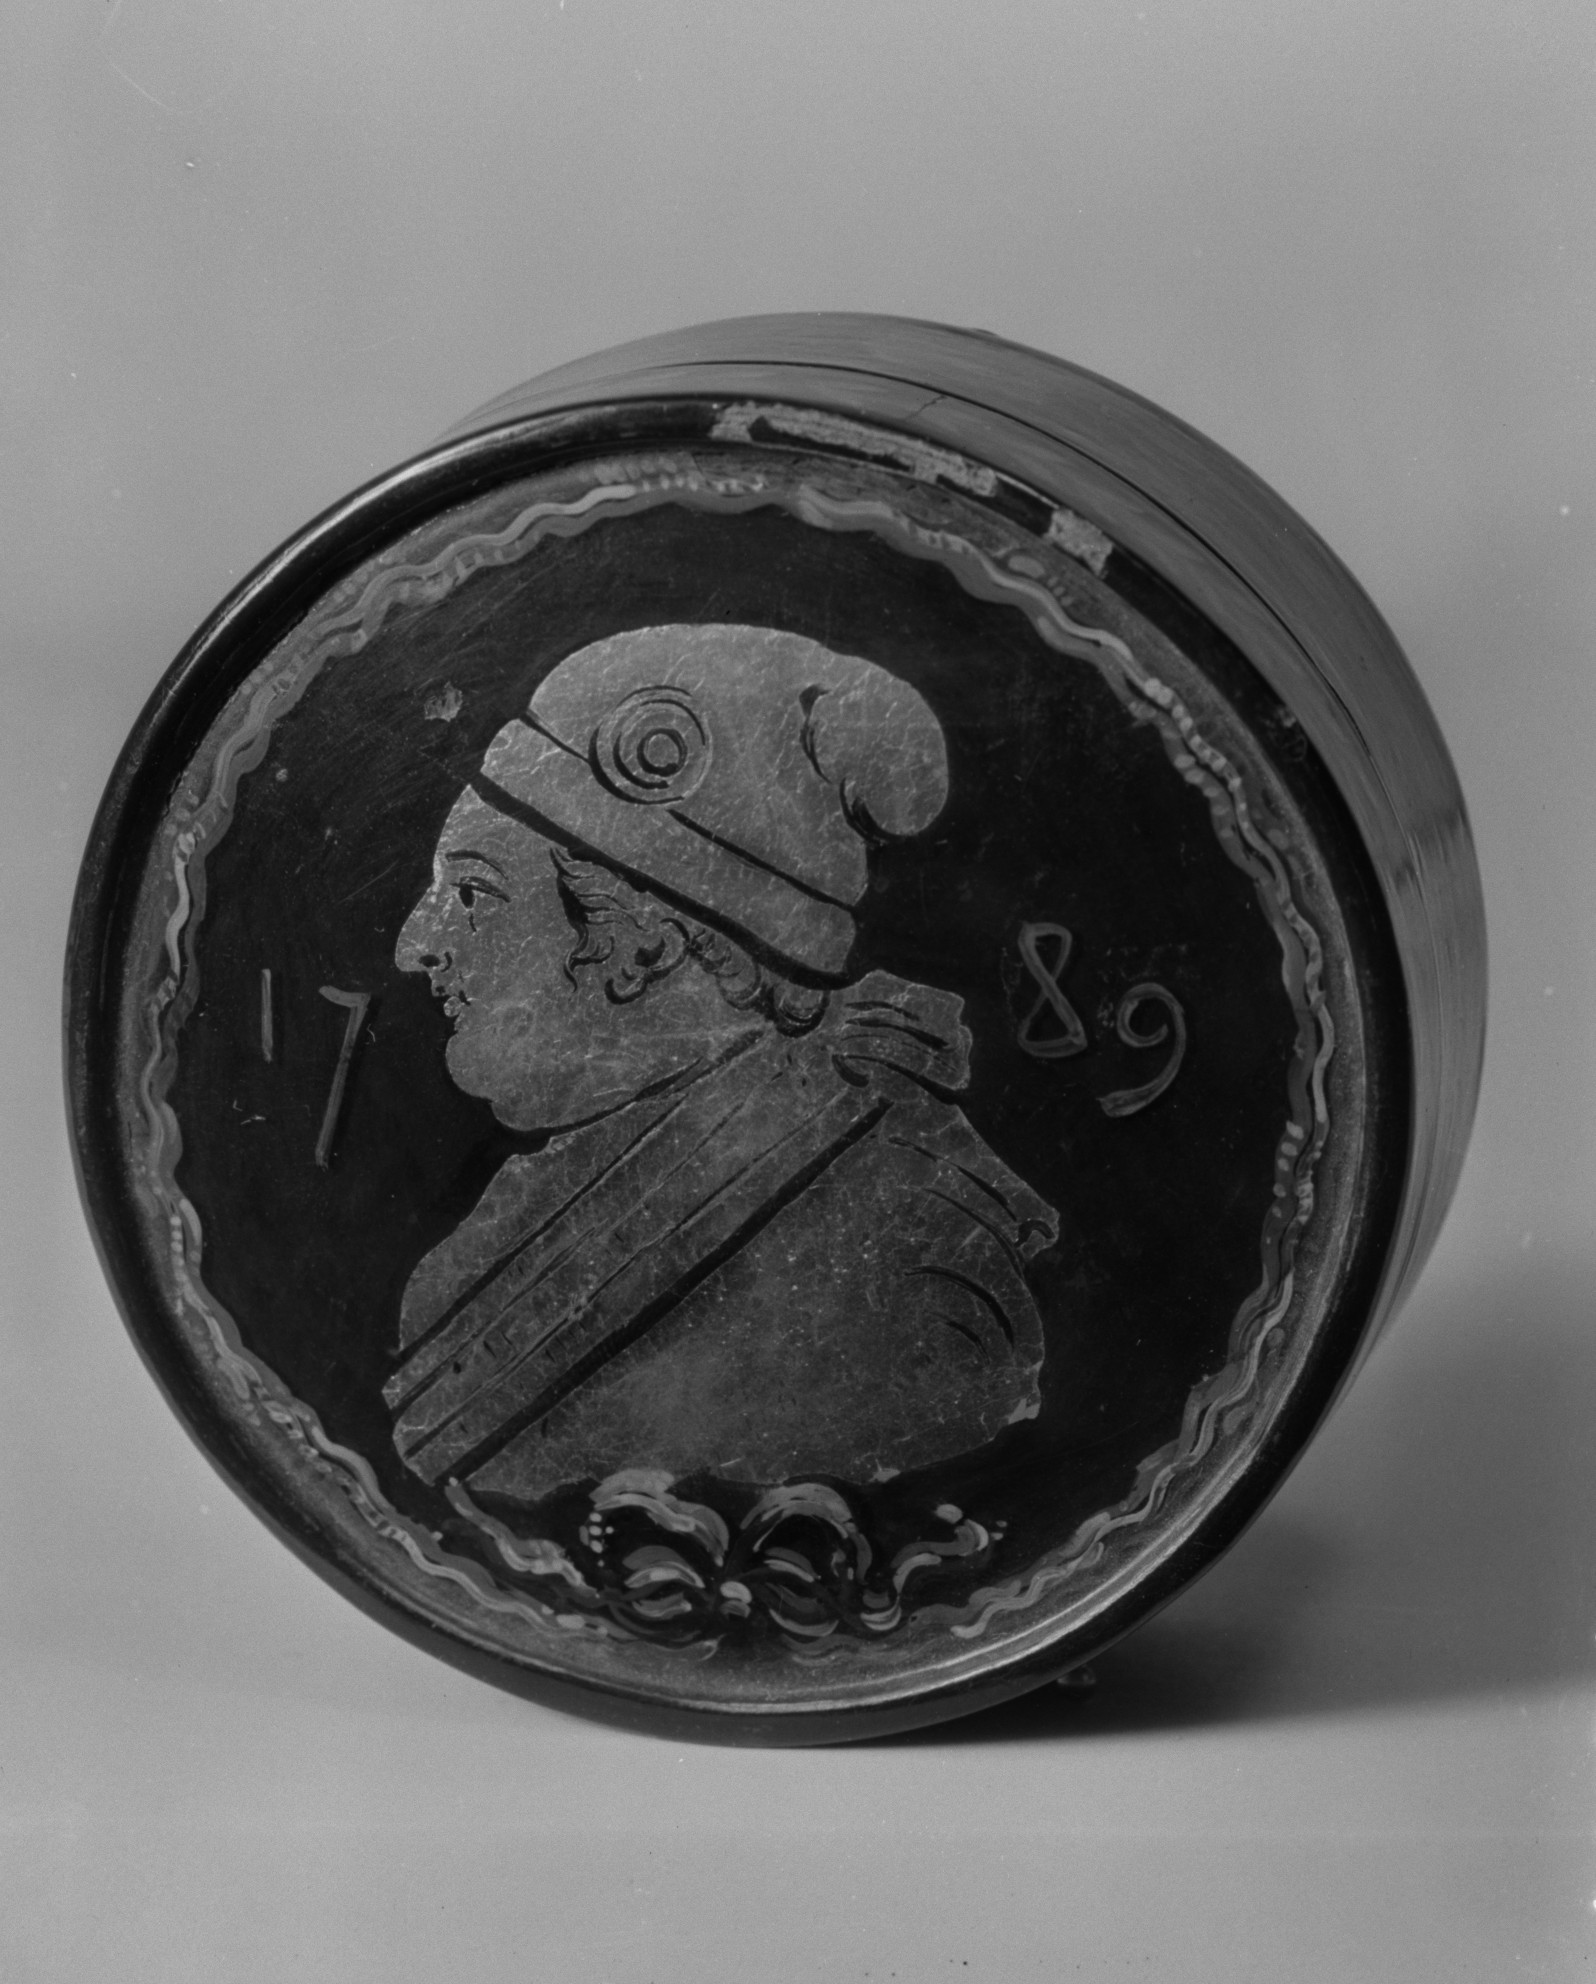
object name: box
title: Box with portrait of Louis XVI in Phrygian cap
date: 1789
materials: horn, paper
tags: kings,profiles